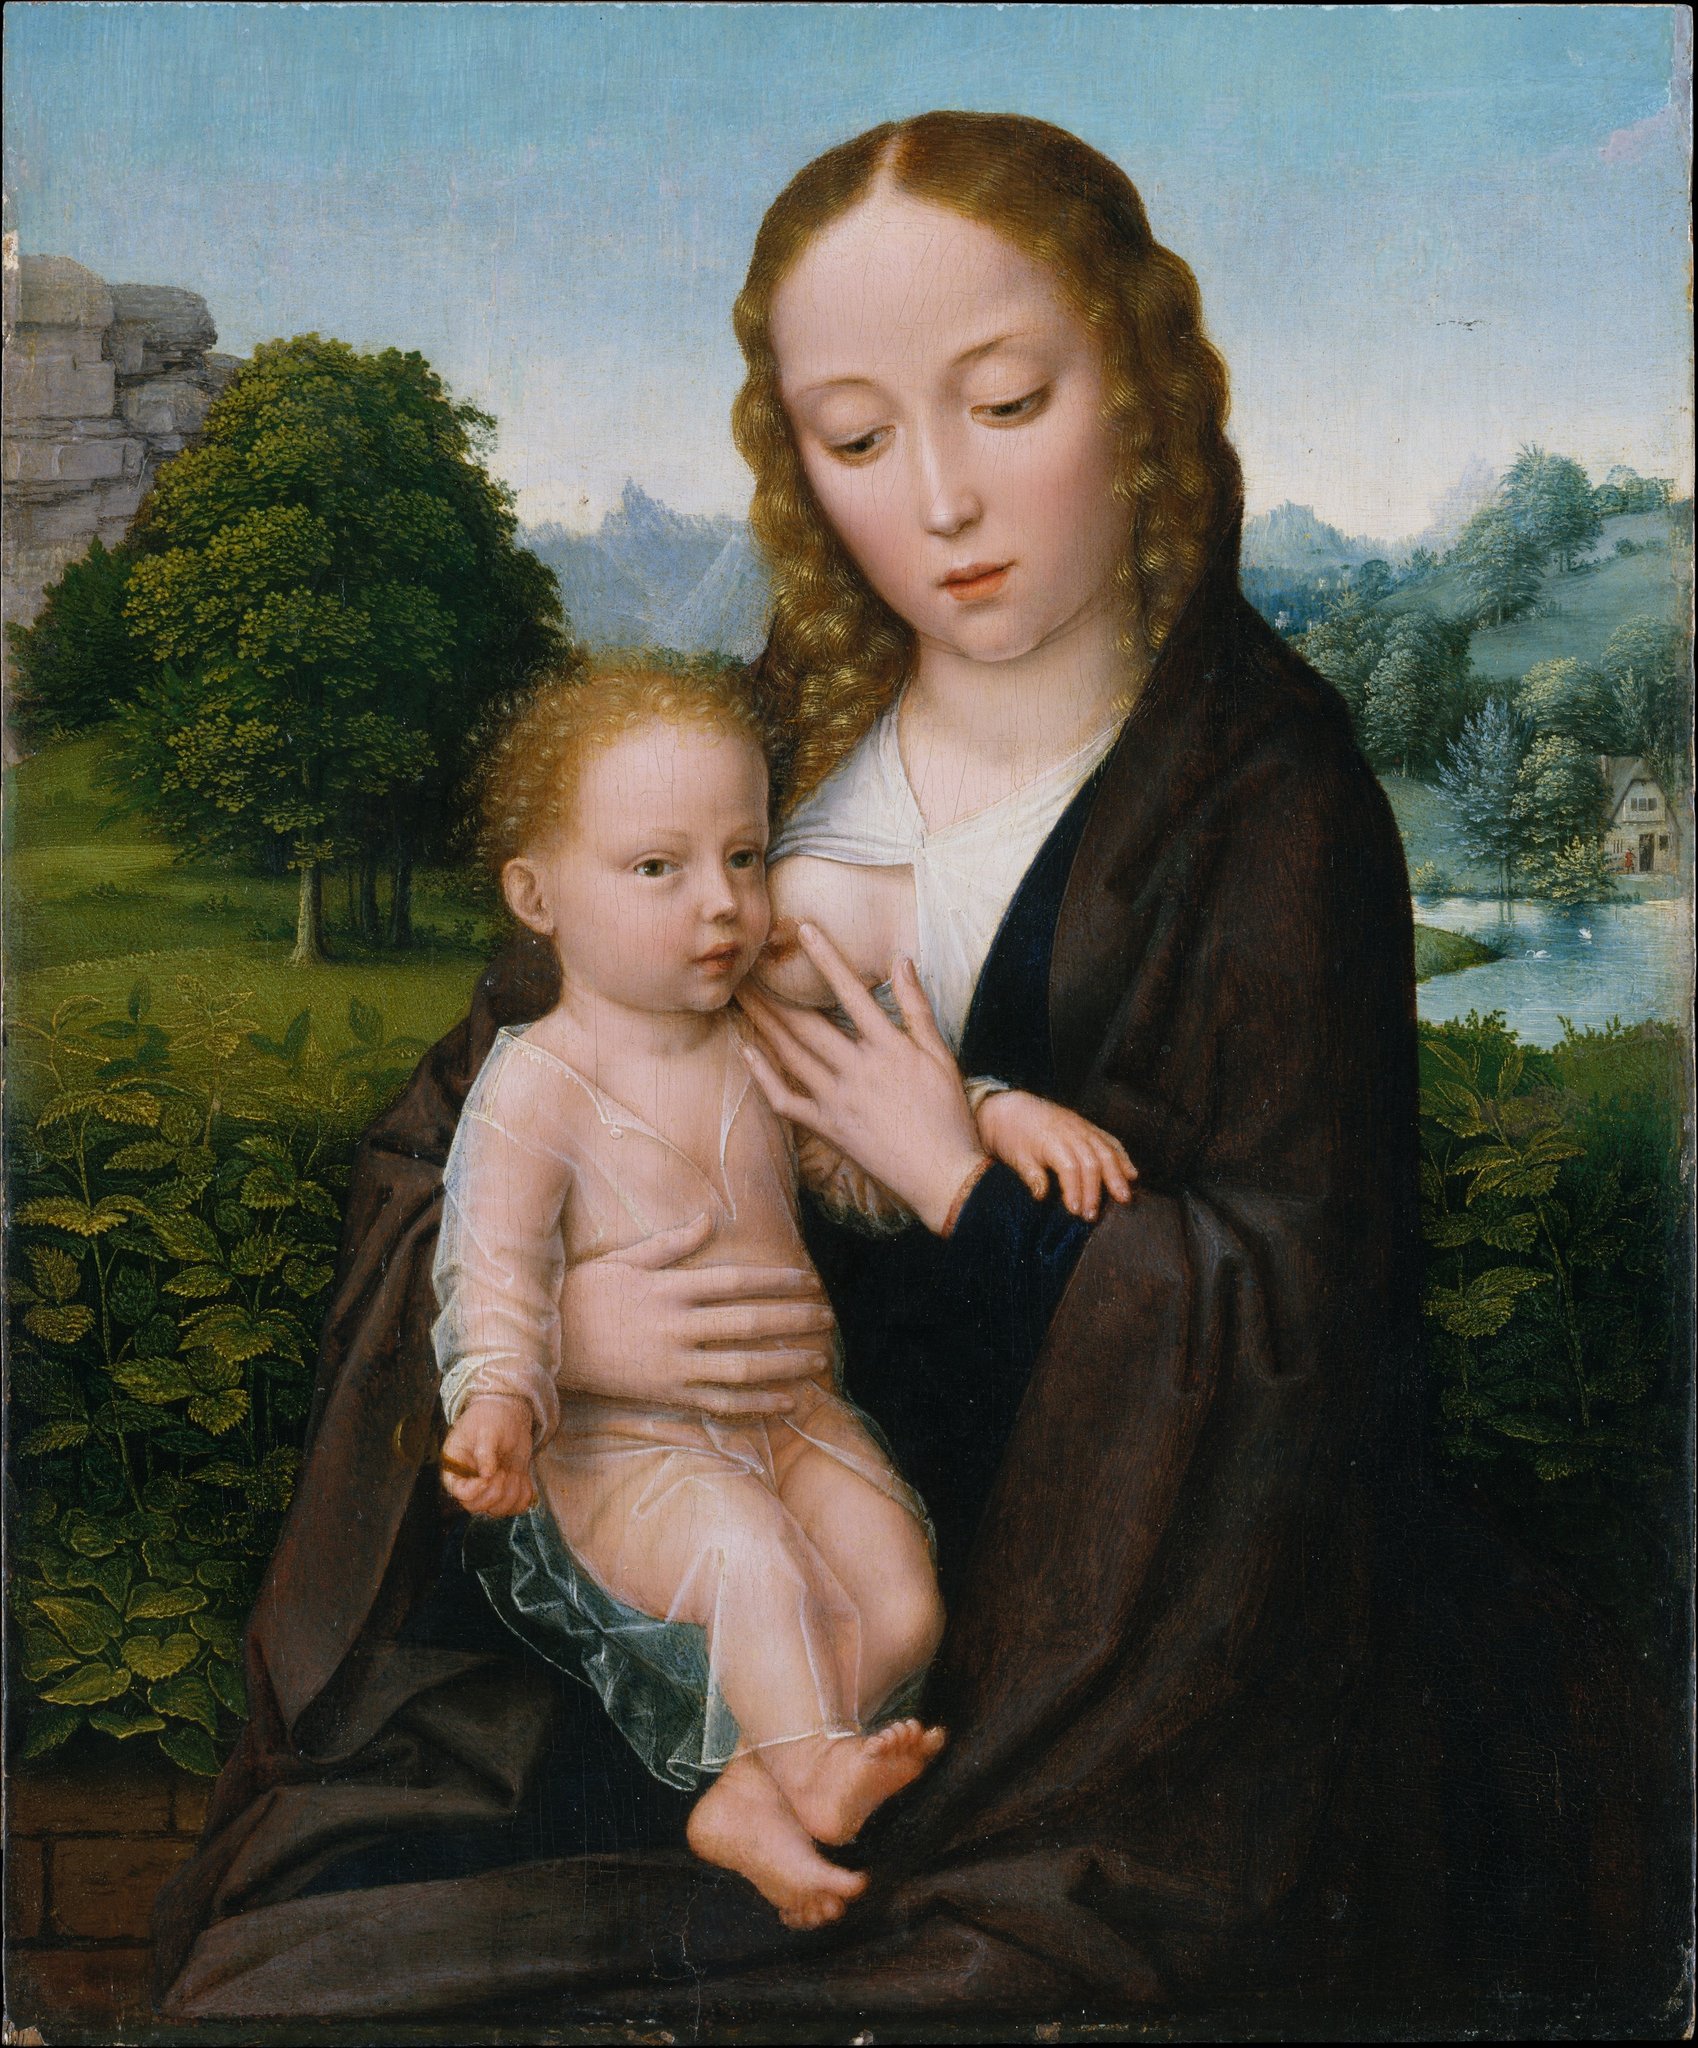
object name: painting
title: Virgin and Child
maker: gerard david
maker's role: artist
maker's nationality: netherlandish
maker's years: 1455-1523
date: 1520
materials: oil, wood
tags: madonna and child,nursing